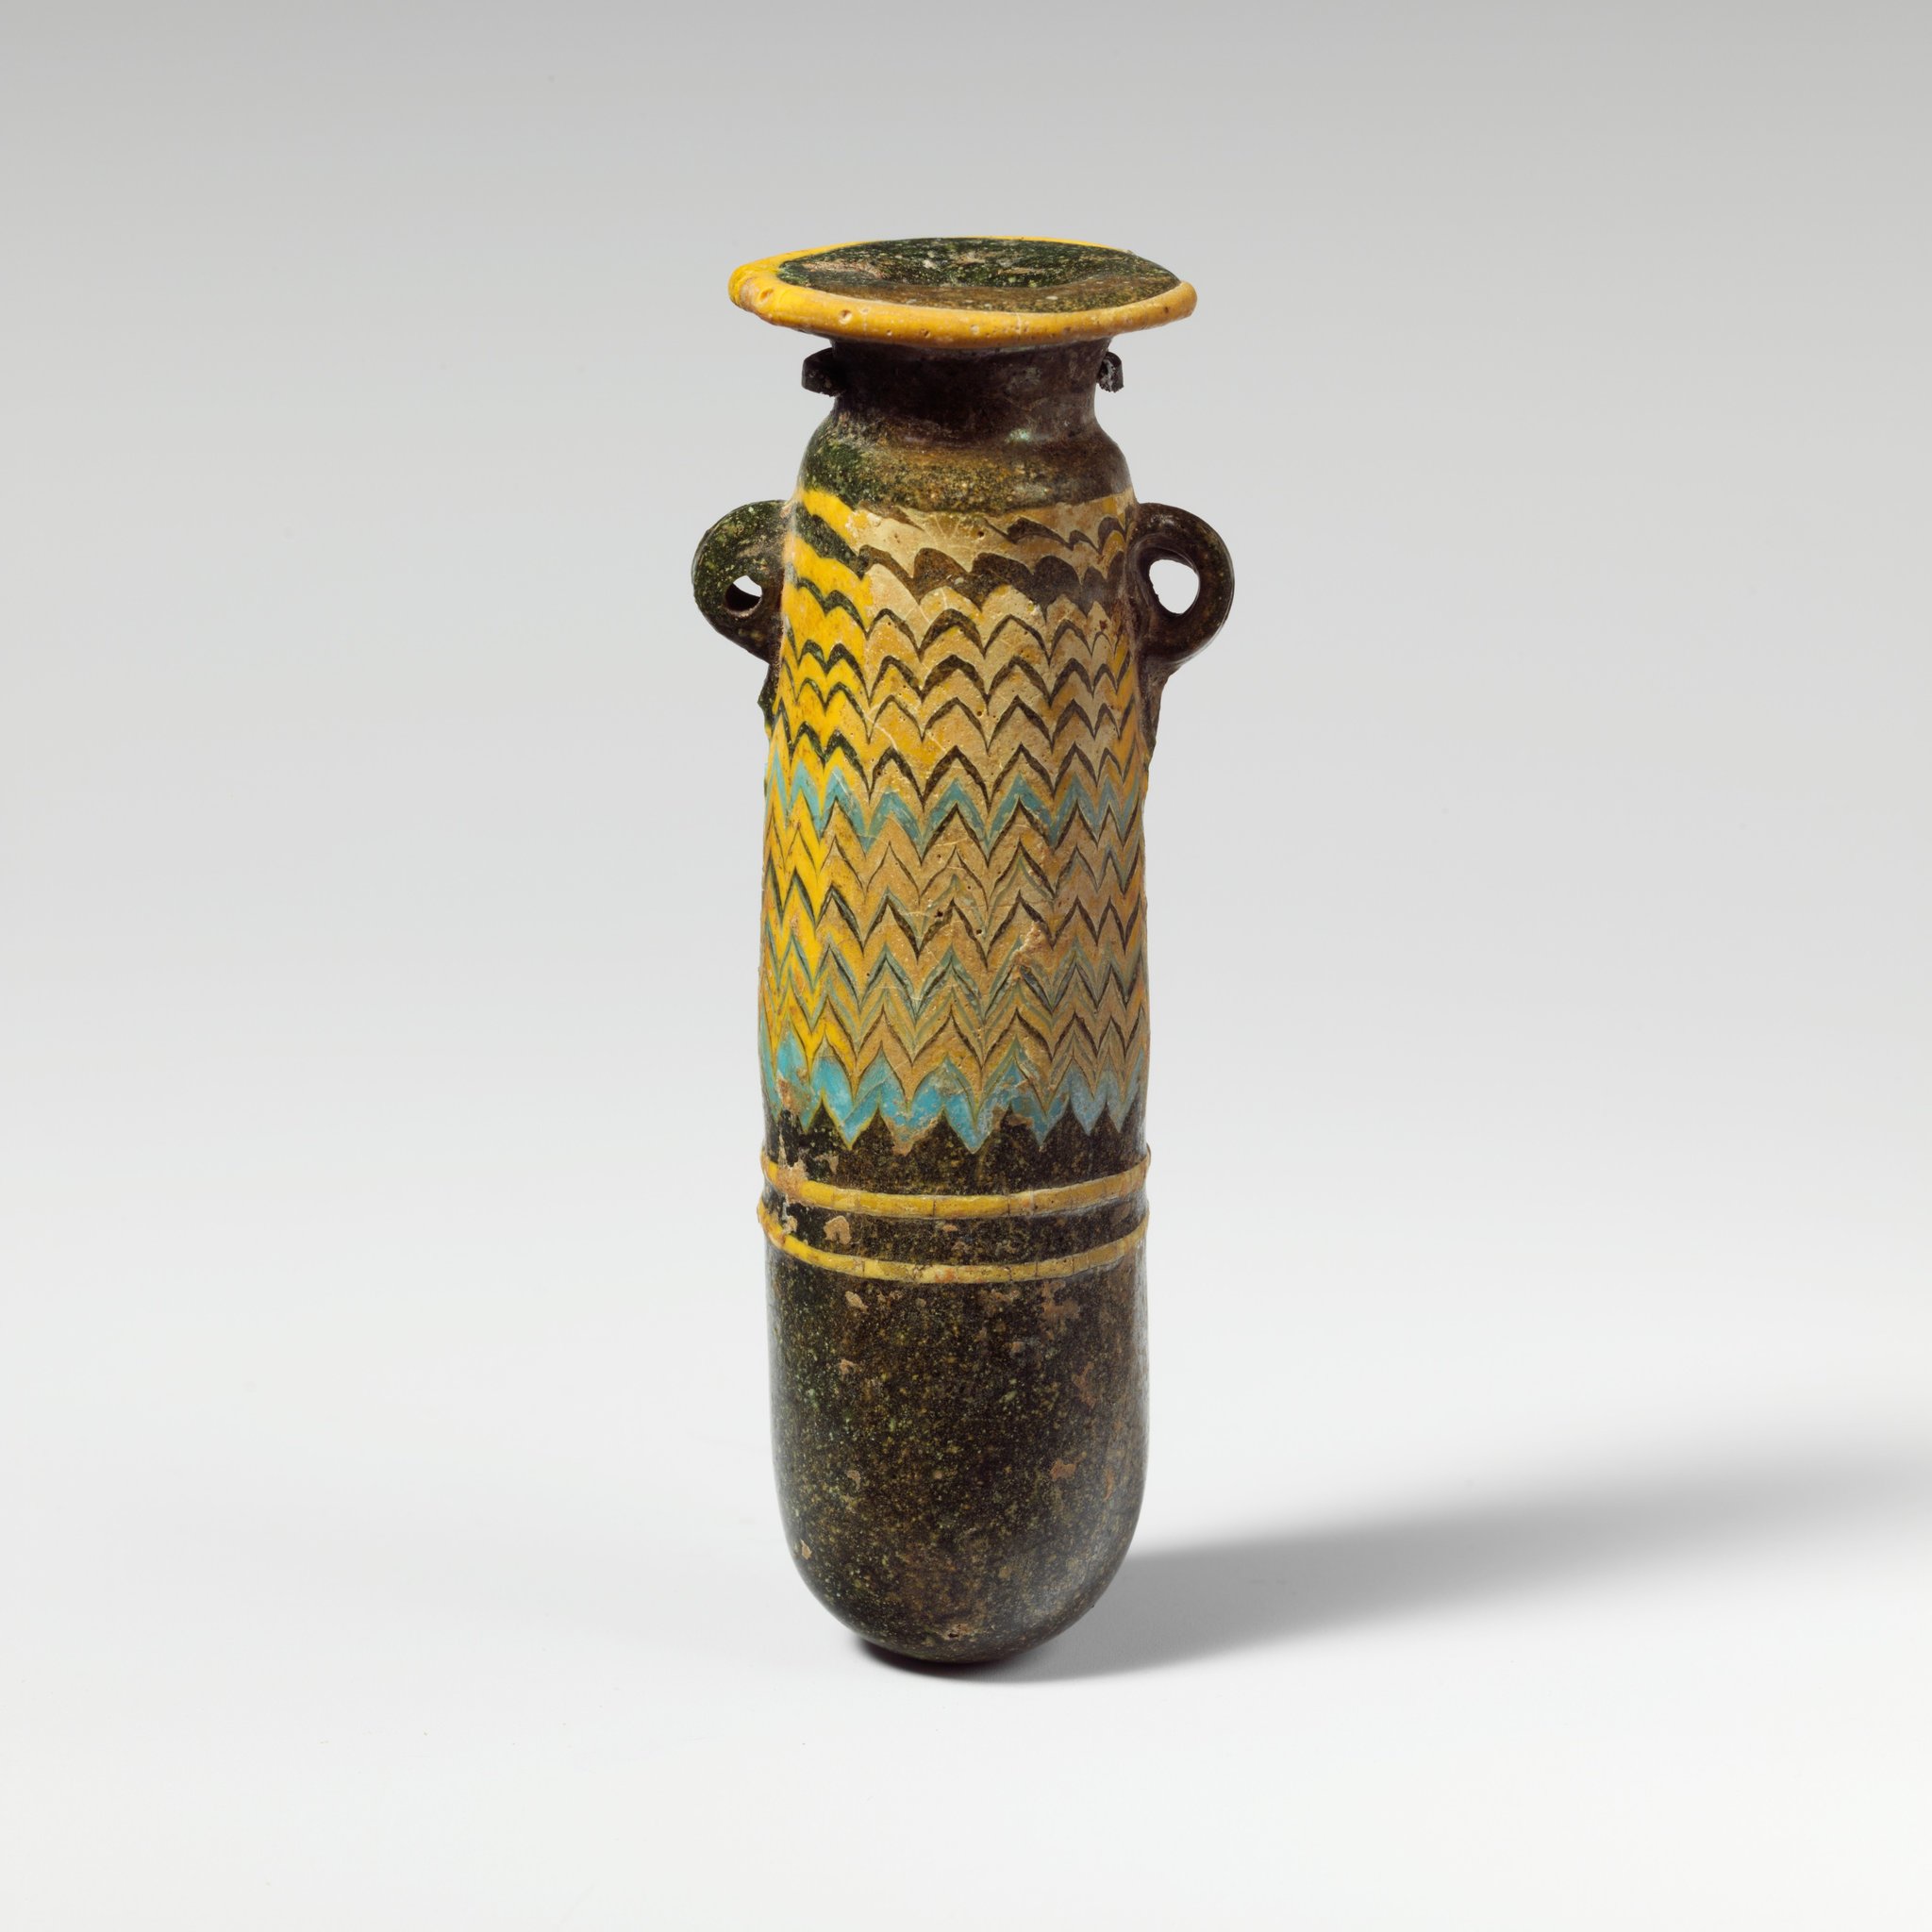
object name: alabastron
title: Glass alabastron (perfume bottle)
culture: greek, eastern mediterranean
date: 534-401 BCE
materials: glass